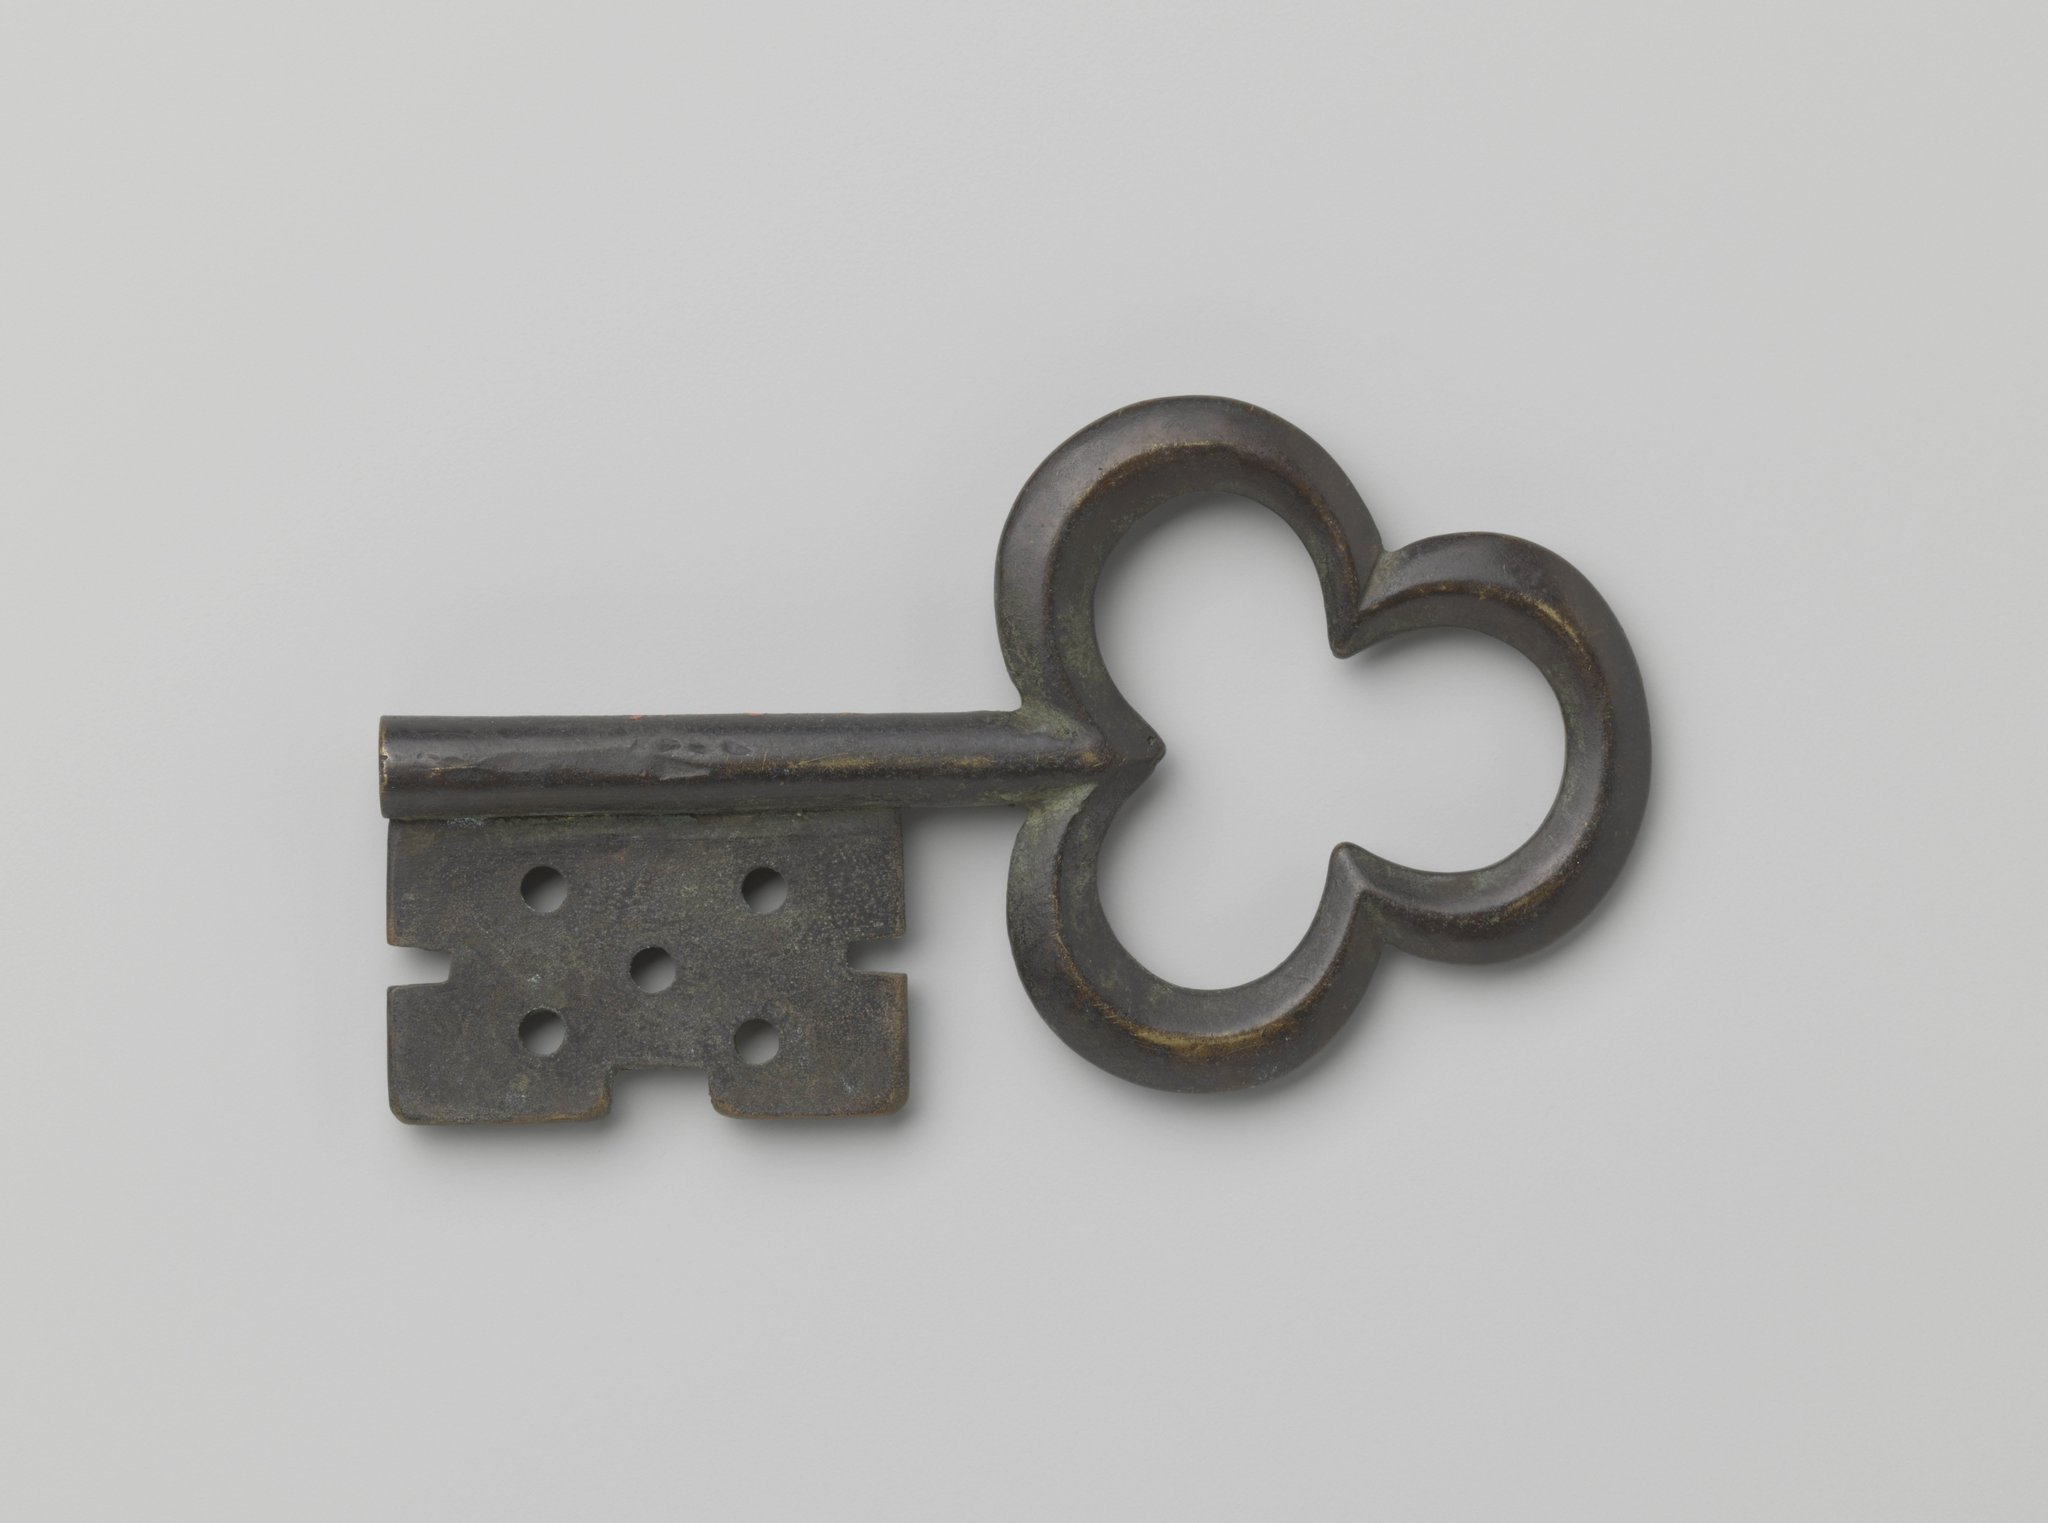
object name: key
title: Sleutel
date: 1400-1500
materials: bronze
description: Sleutel met driepasvormig oog. De vlakke baard heeft vijf gaatjes.